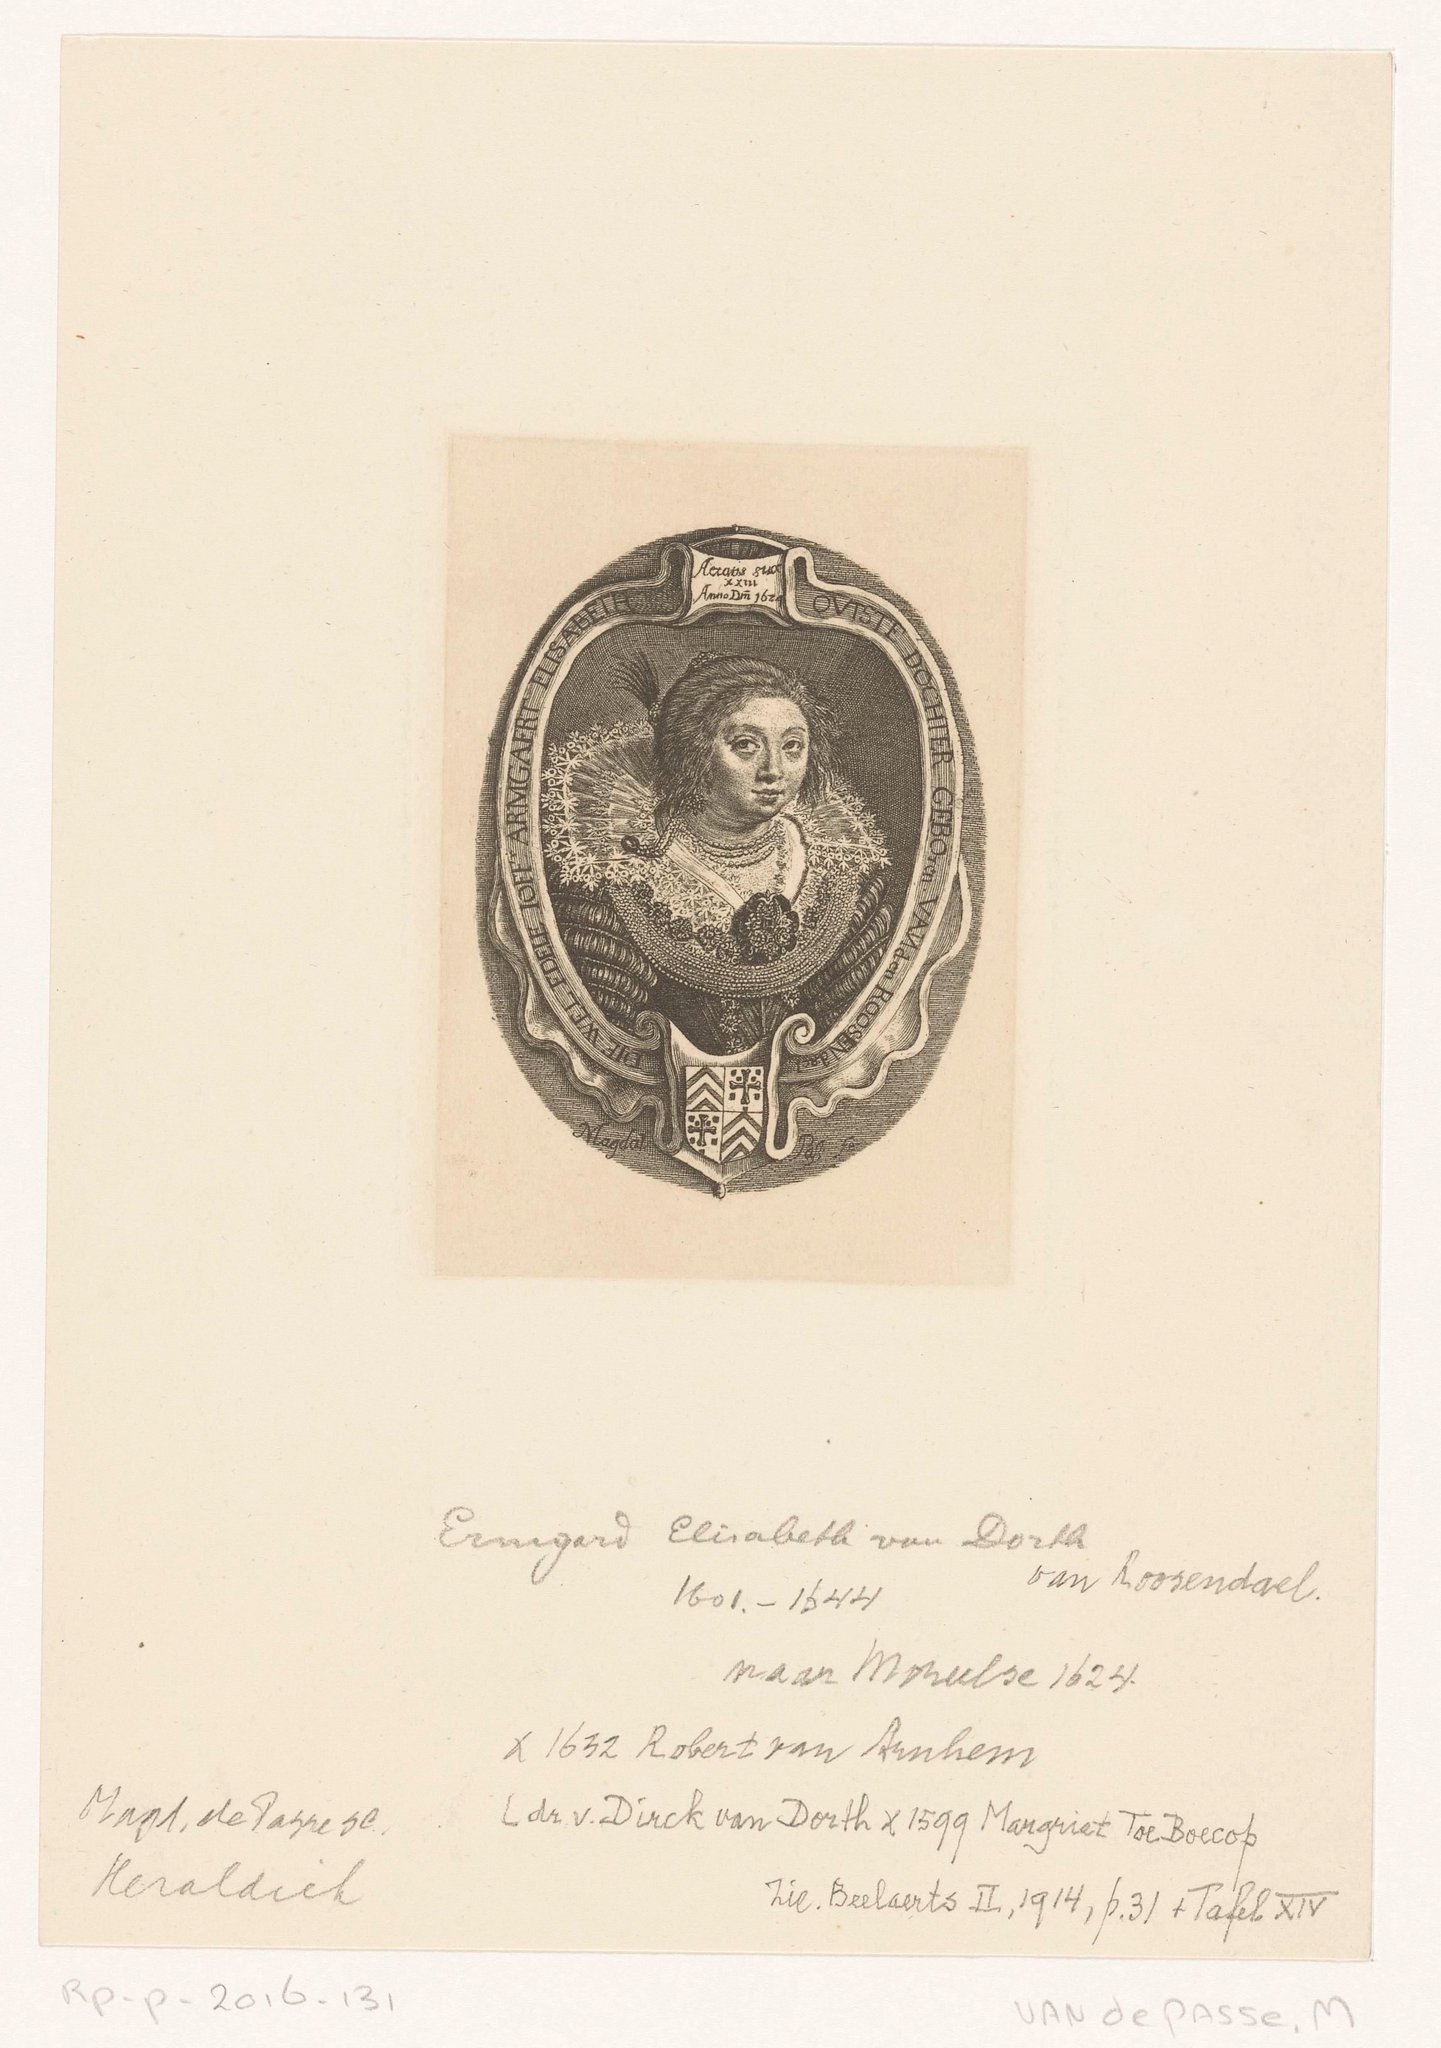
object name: print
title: Portret van Ermgard Elisabeth van Dorth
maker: magdalena van de passe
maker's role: print maker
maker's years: 1600-1638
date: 1624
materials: paper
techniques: etching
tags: historical persons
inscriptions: inscription: ‘Reproduction’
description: Portret van Ermgard Elisabeth van Dorth in ovale omlijsting met naam en titel. Aan de onderzijde haar familiewapen.